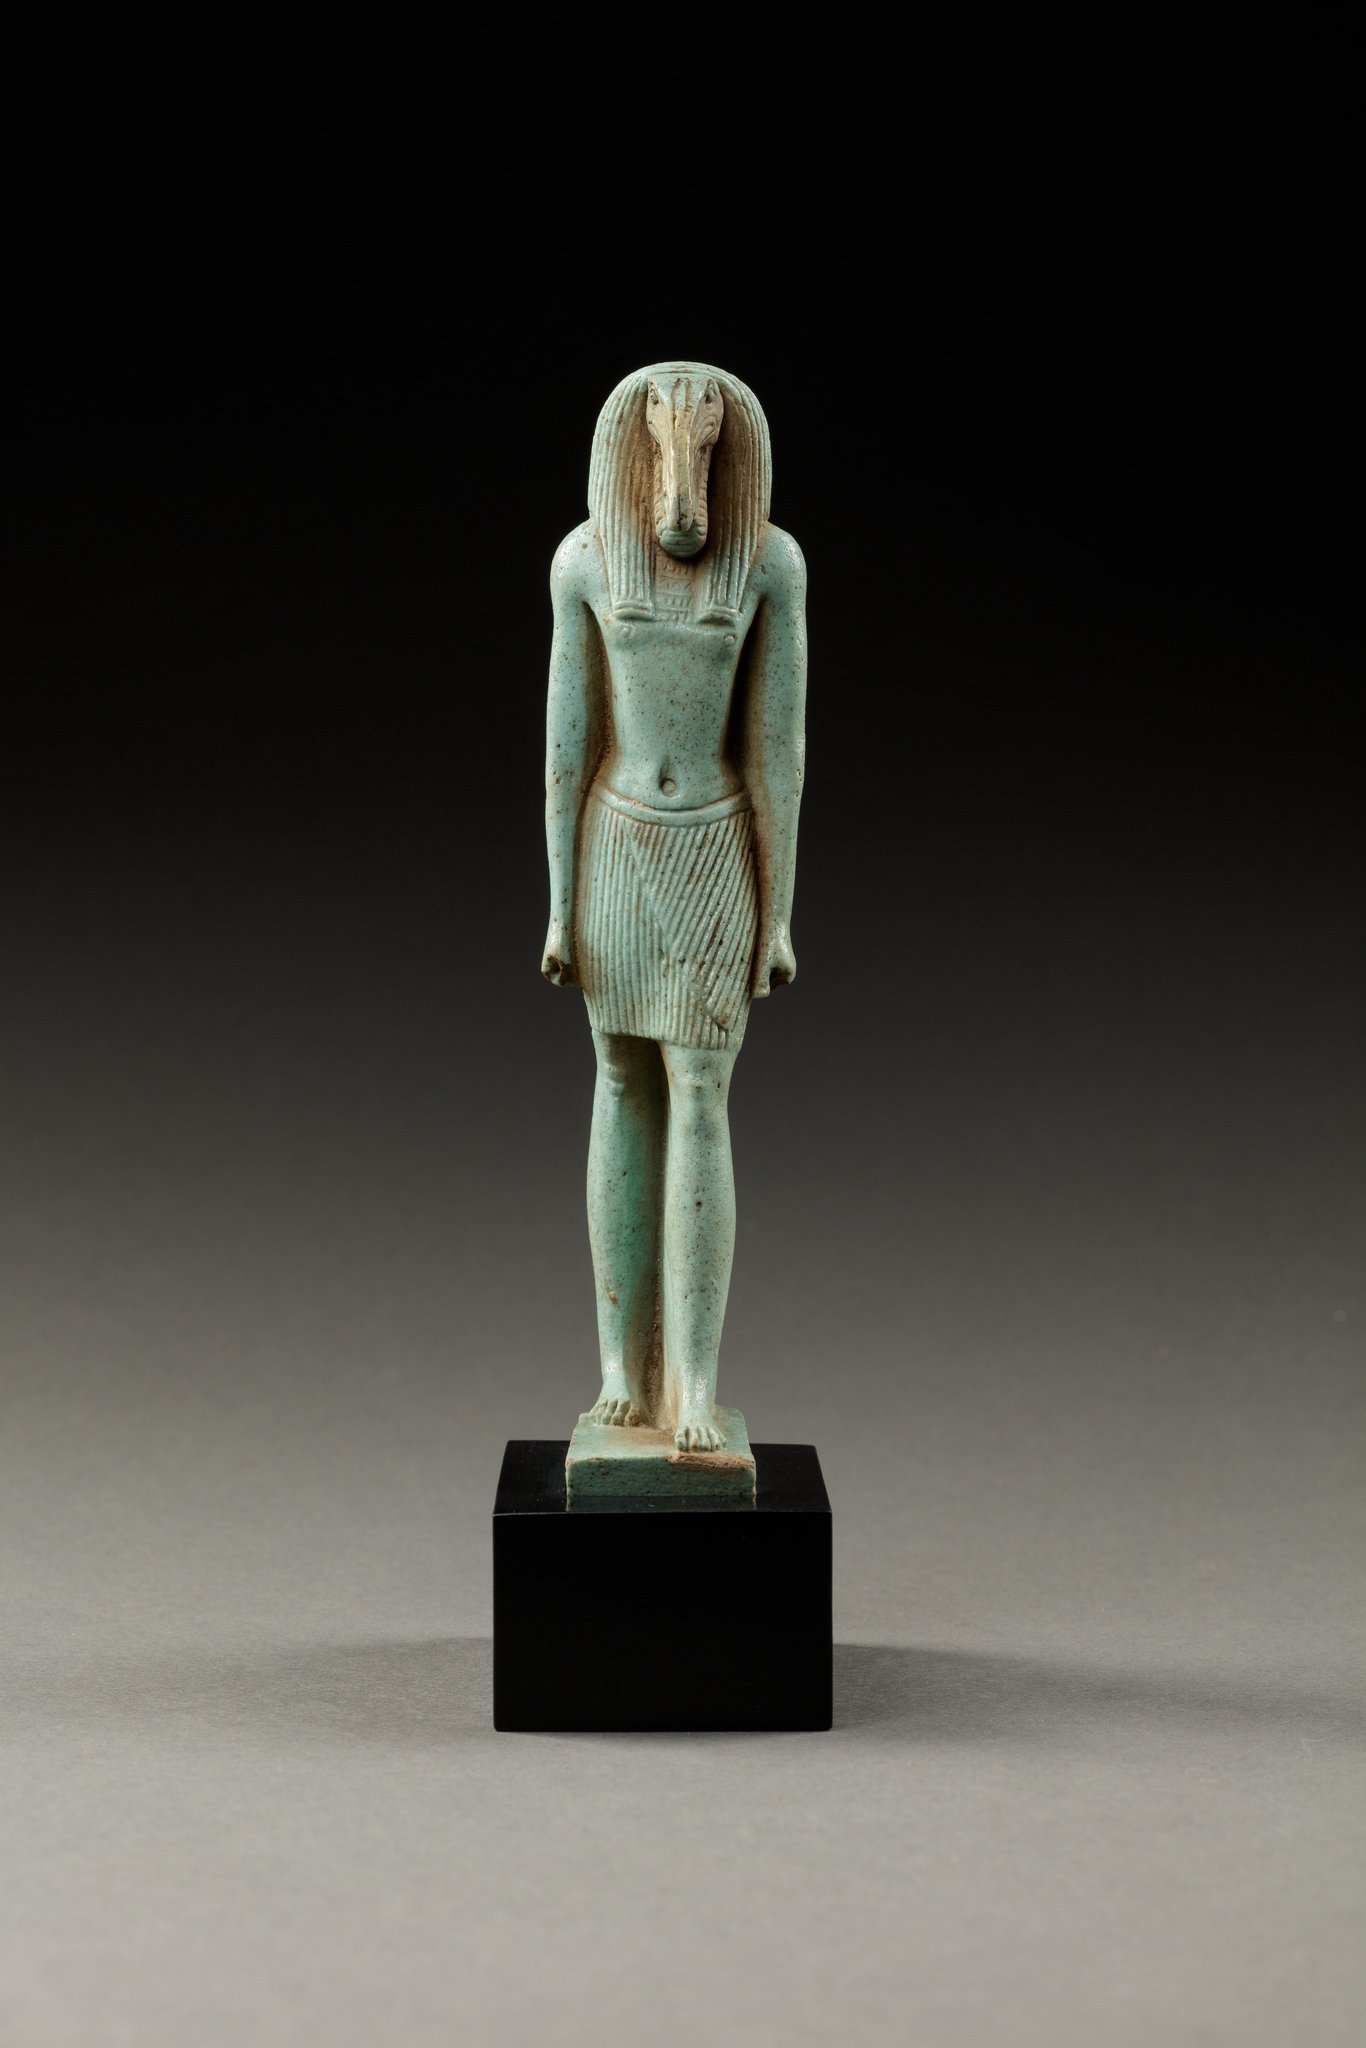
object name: ibis, striding, thoth, amulet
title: Striding Thoth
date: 664-332 BCE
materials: faience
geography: egypt